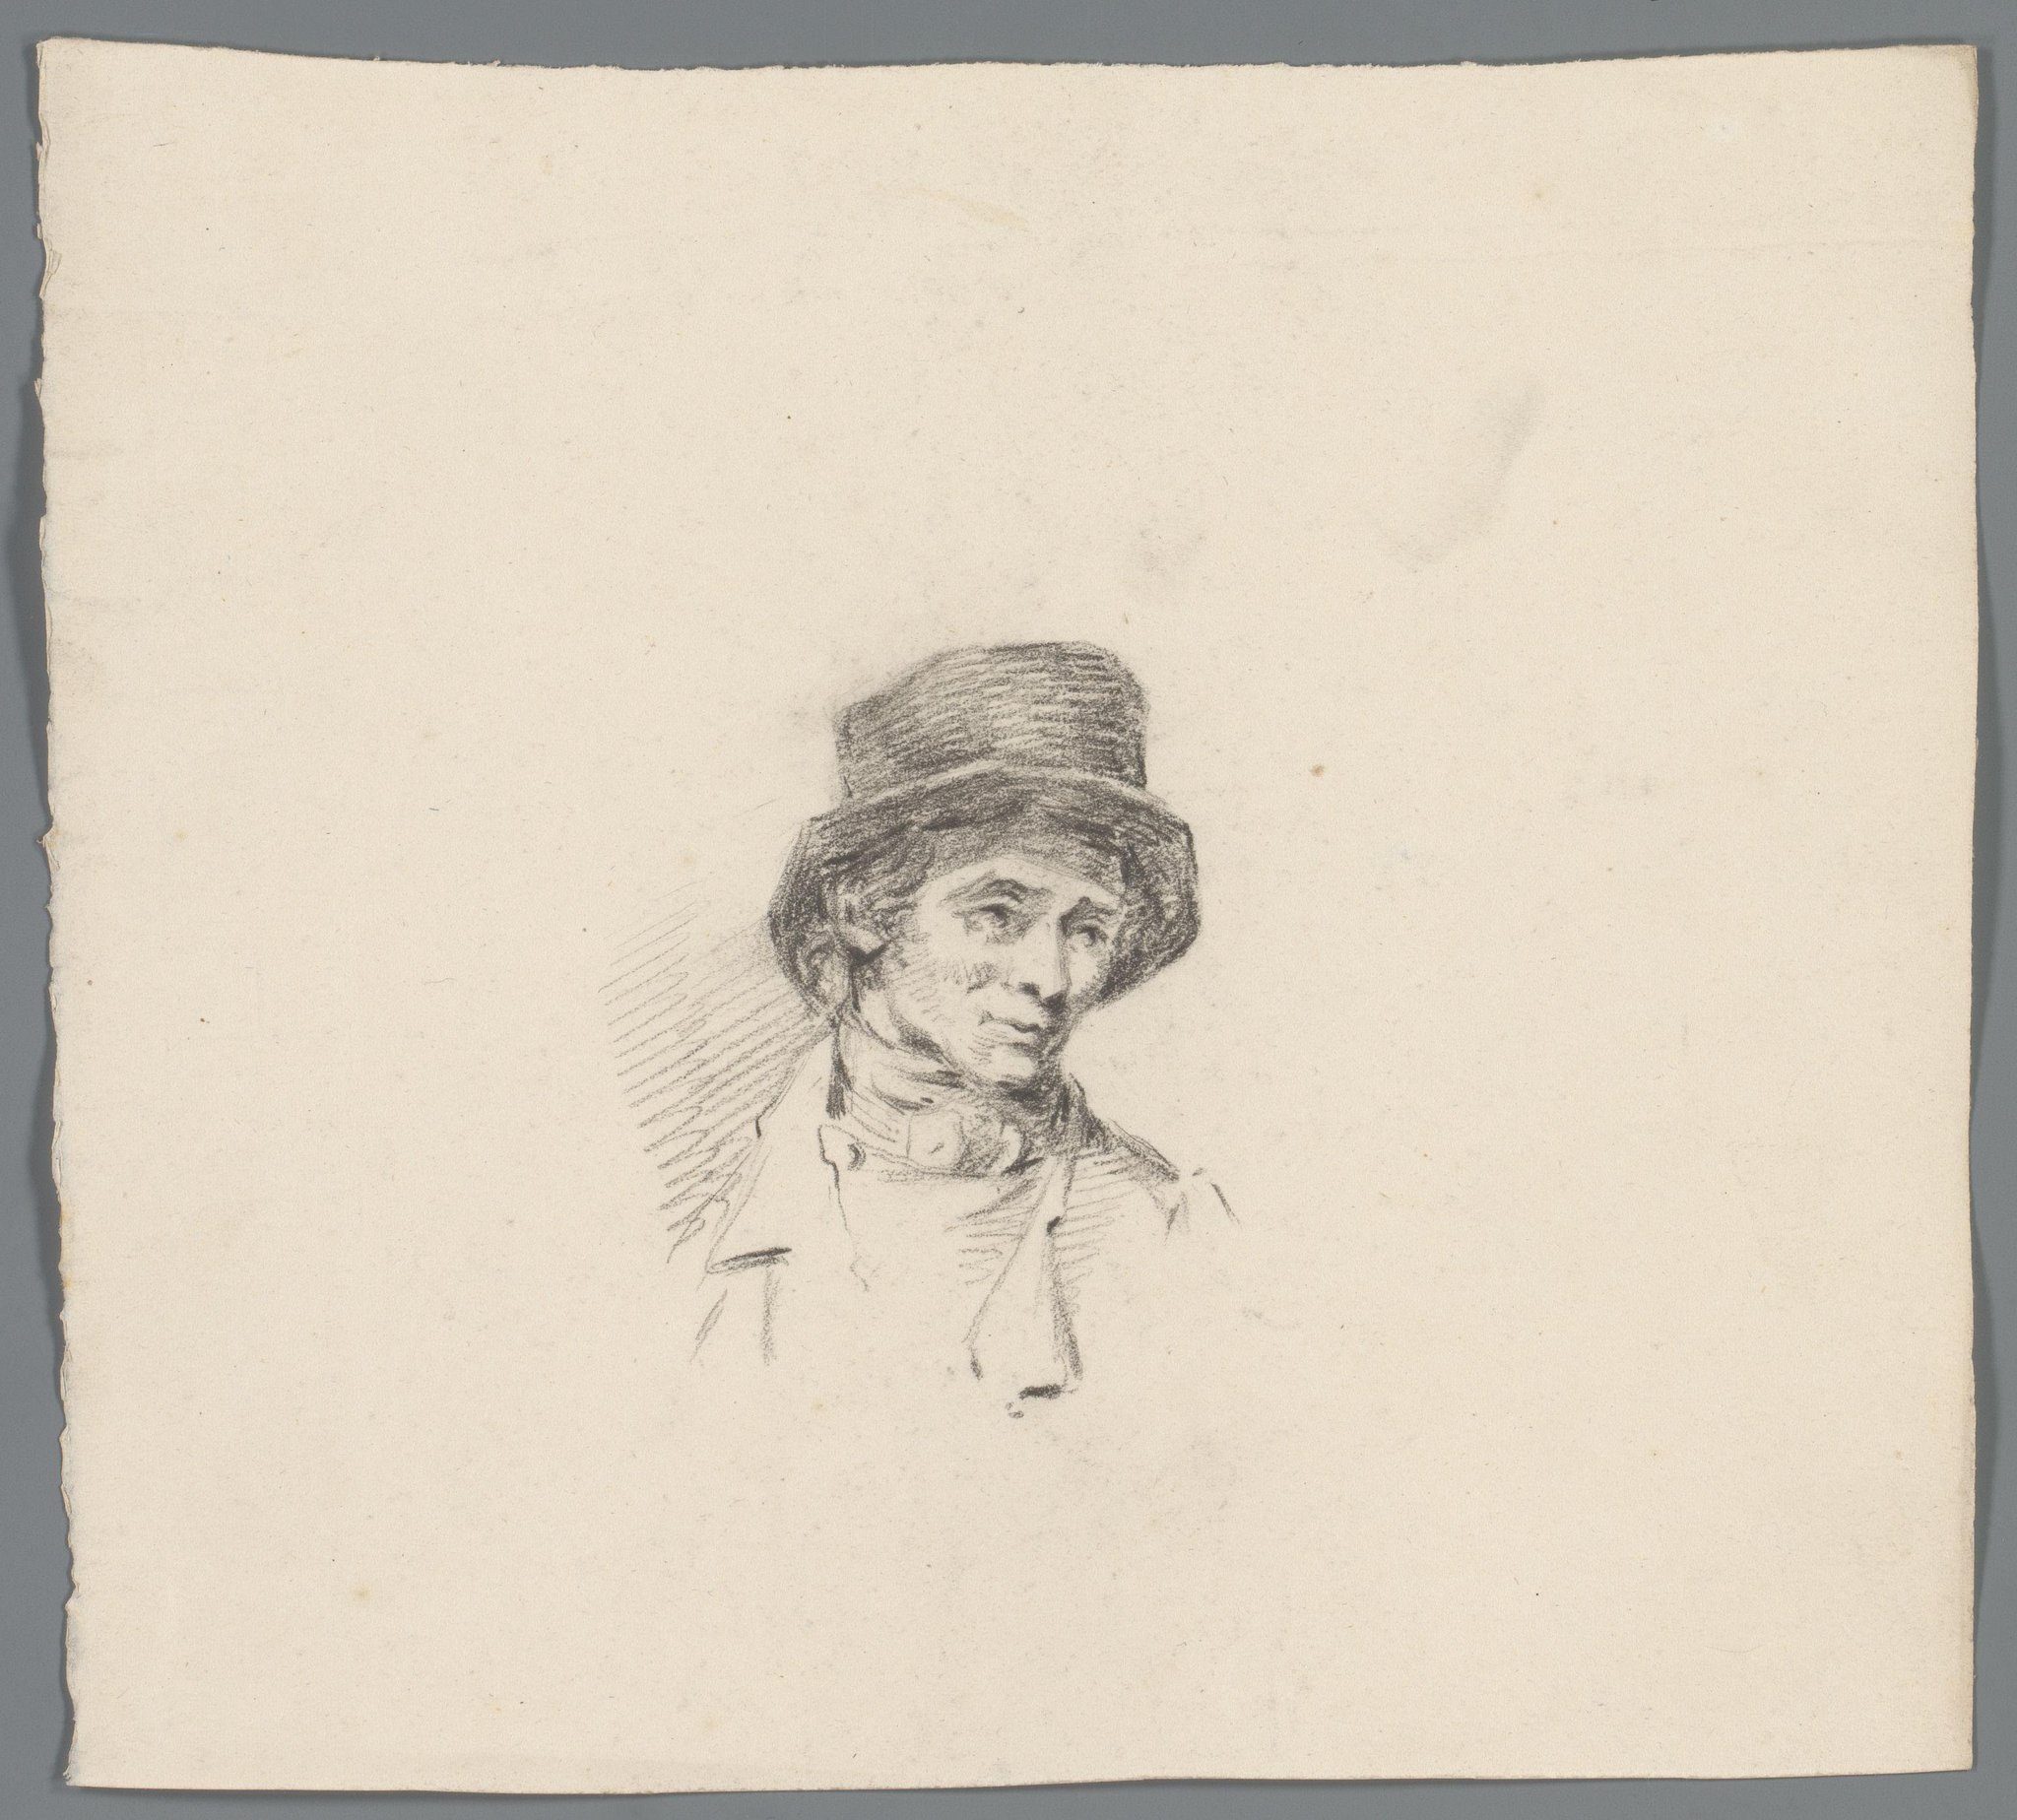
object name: drawing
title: Portret van een onbekende man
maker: Anonymous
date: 1820-1830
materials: chalk, paper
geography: the hague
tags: head-gear: hat, historical persons not known by name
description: Tekeningen waarschijnlijk ontstaan bij het Haagse kunstgenootschap ‘Tot Nut der Tekenkunst’, waar twee keer per week tekenavonden werden georganiseerd met geklede modellen.